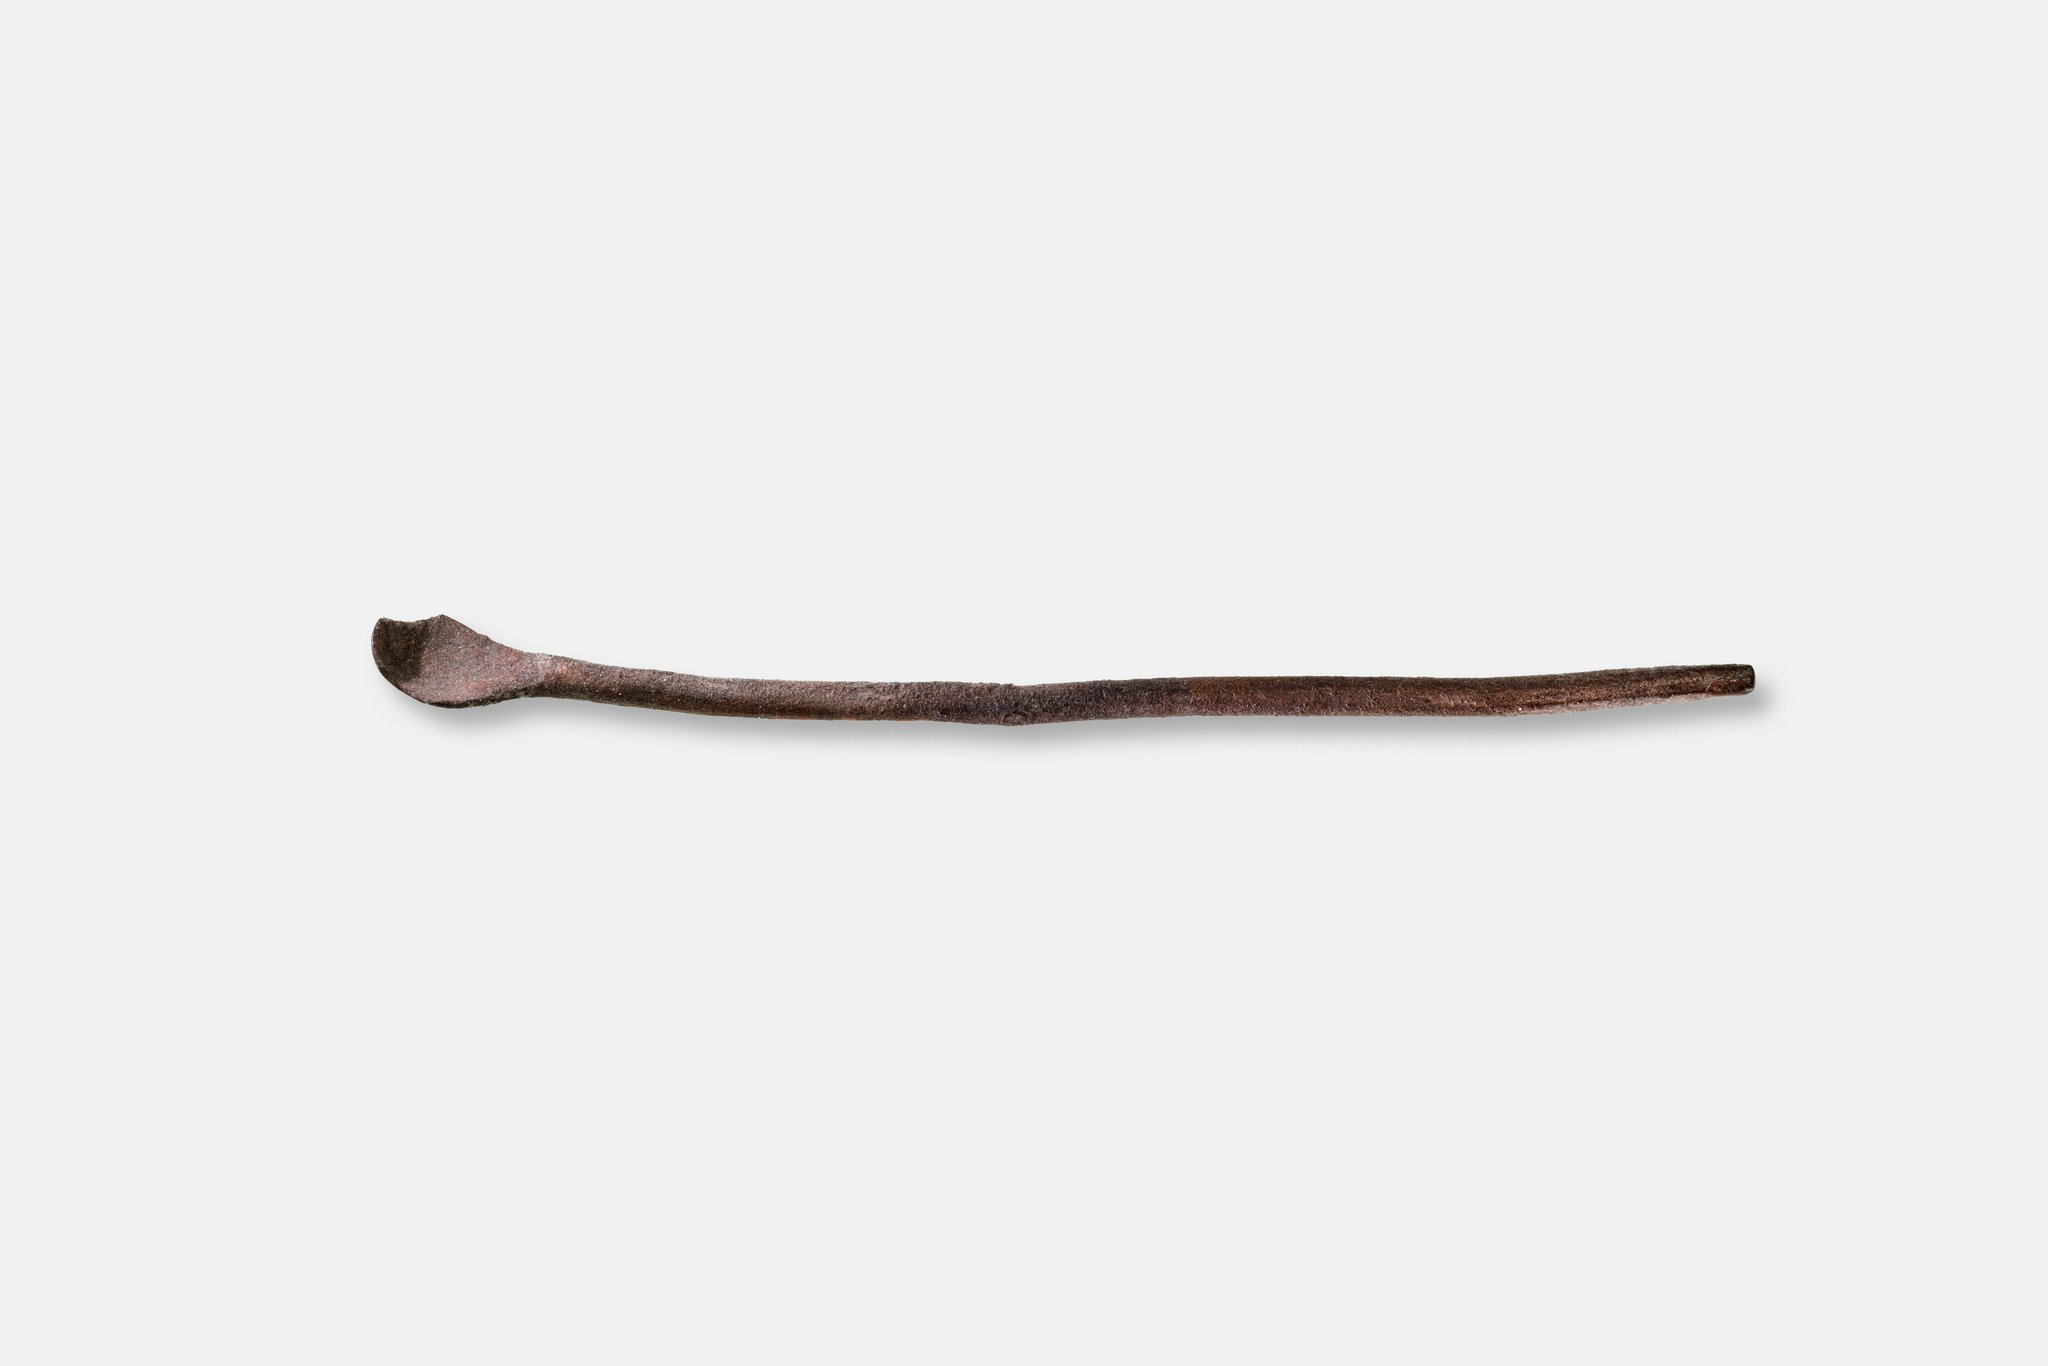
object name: spoon, ruiu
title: Cosmetic Spoon of Ruiu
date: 1504-1447 BCE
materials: bronze, copper alloy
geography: egypt